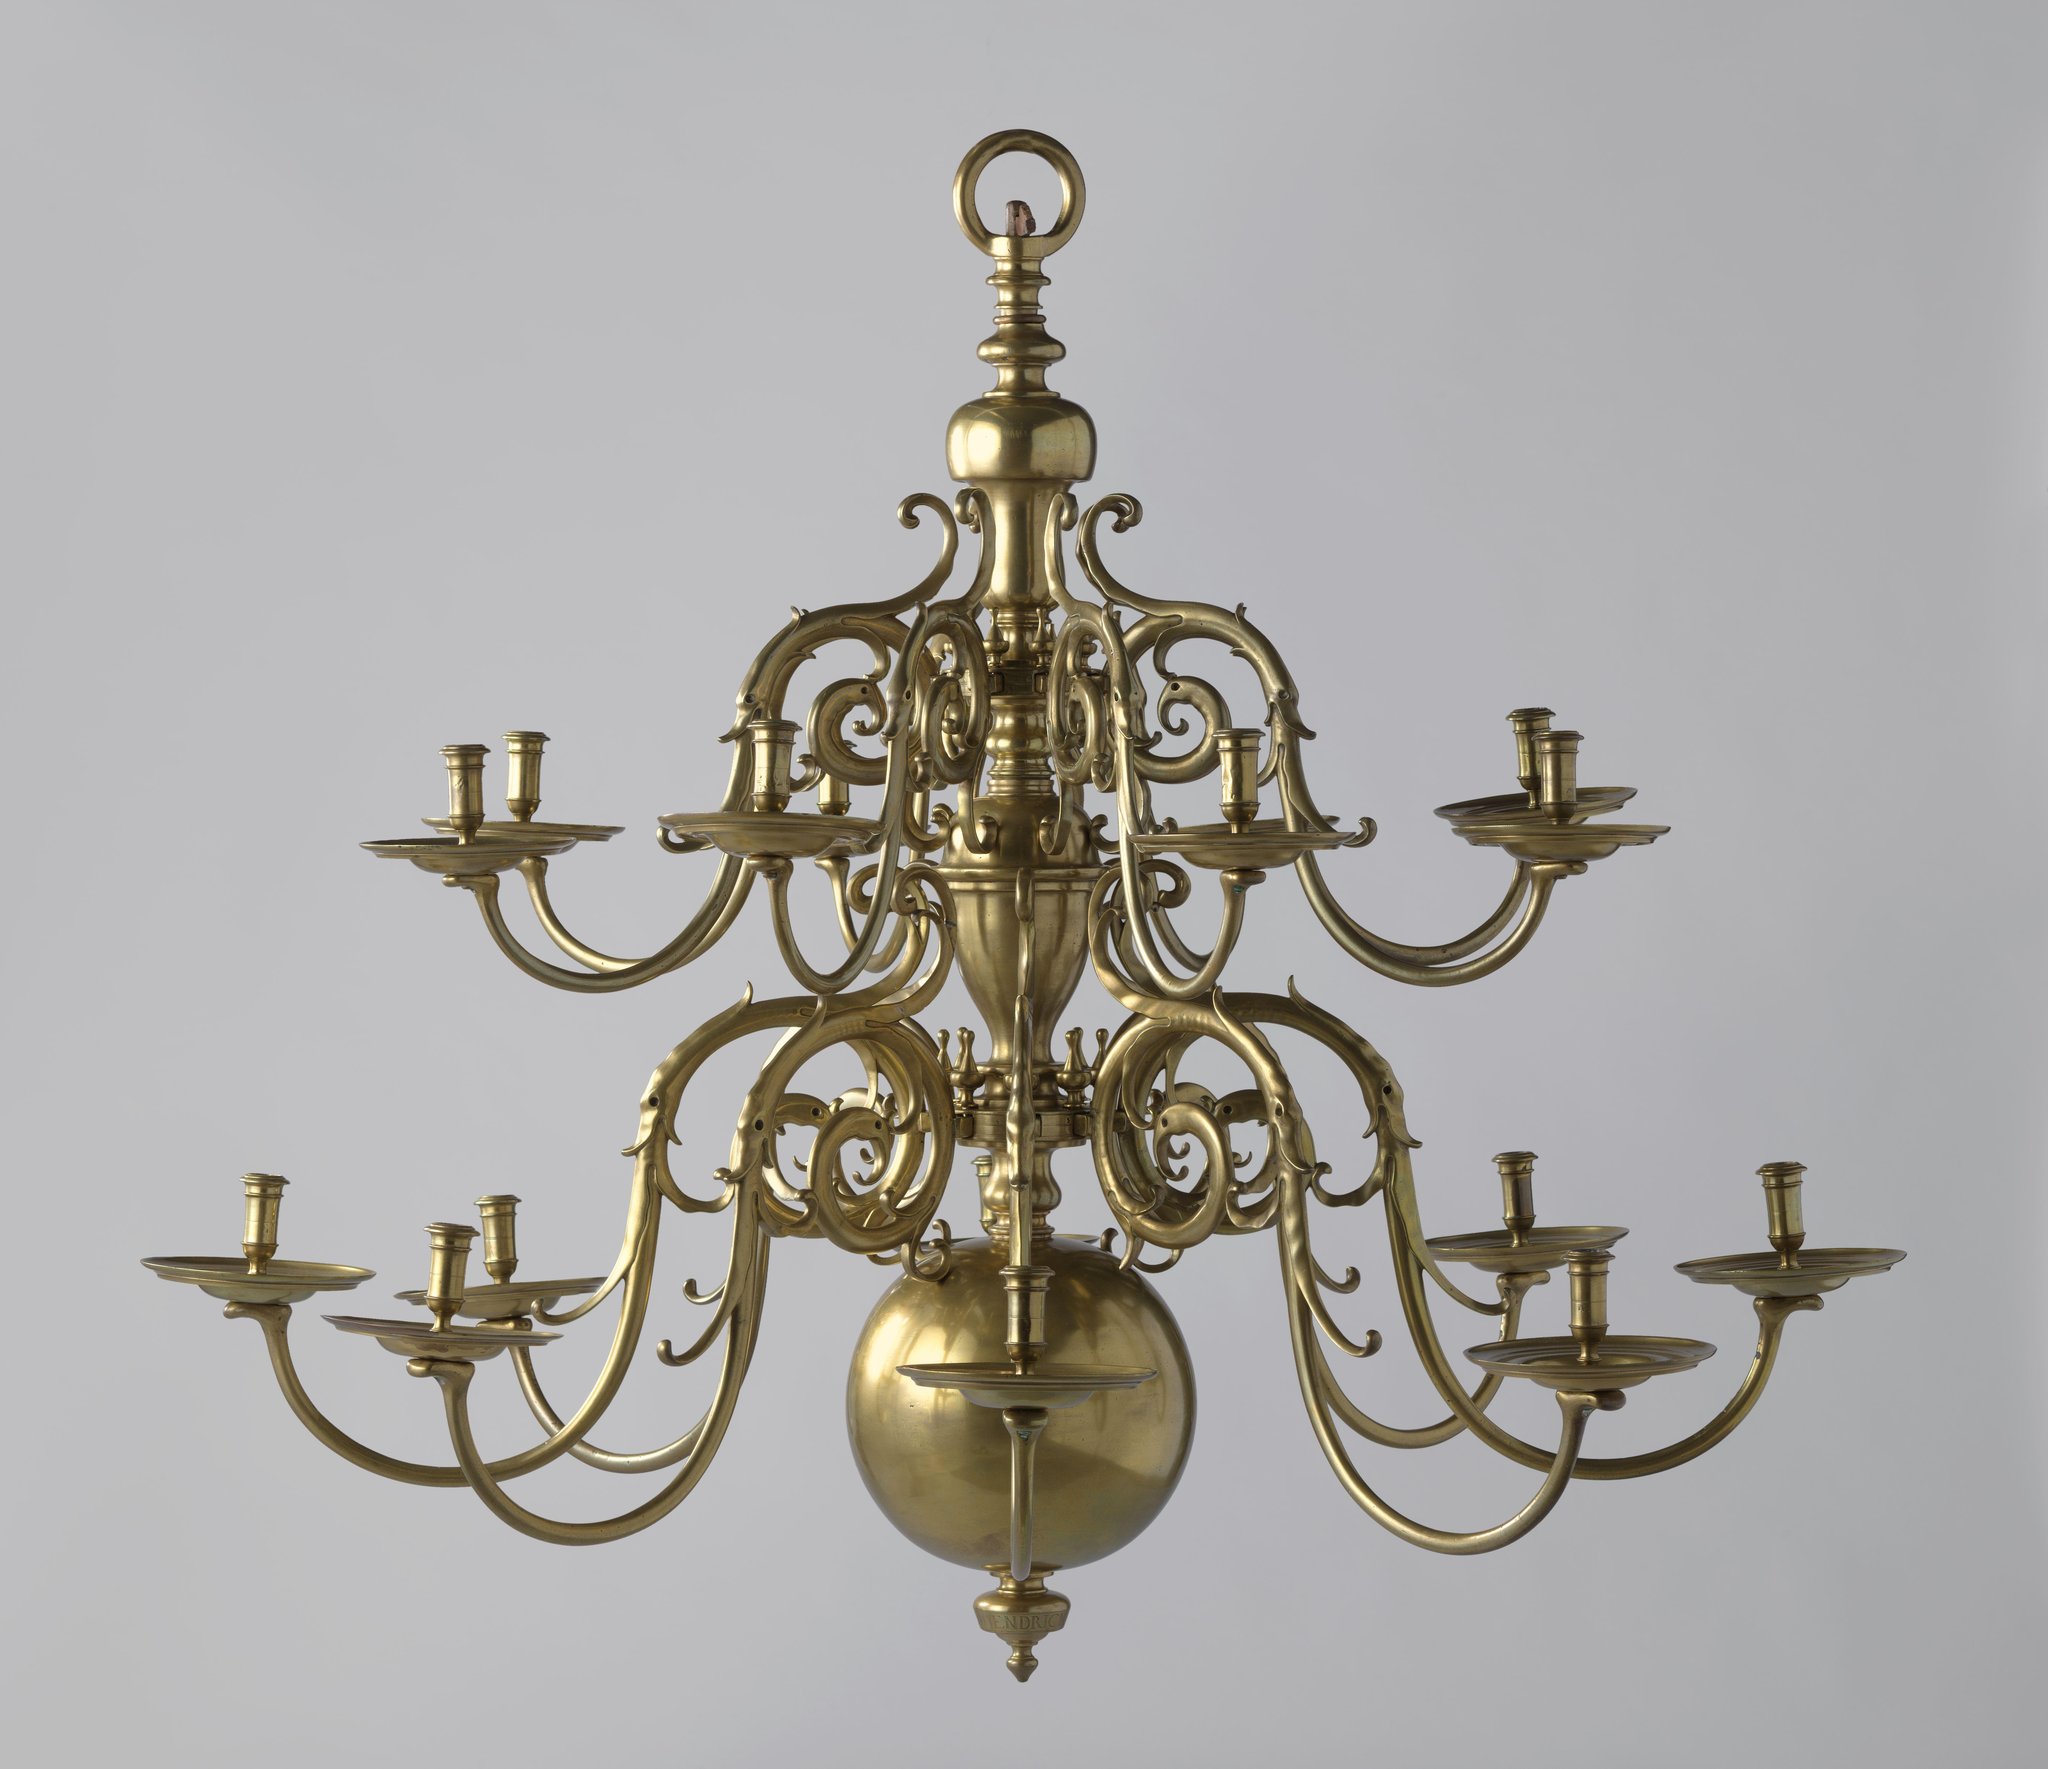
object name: chandelier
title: Arm met kaarsenhouder van kaarsenkroon van twee hoogten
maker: Anonymous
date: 1650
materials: brass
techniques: casting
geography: amsterdam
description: Kaarsenarm behorende bij een messing kaarsenkroon van twee hoogten. De S-vormige arm heeft een krul bij de aanzet, halverwege een dolfijnenkop en gaat naar buiten toe over in het platte verdikking met een schroefgat. Daarin is de kaarsenhouder met de vetvanger vastgezet. De vetvanger is aan de onderzijde geribd geprofileerd rond de opening en heeft een naar onder en een iets uitstekend randje. De cylindrische kaarsenhouder heeft een geprofileerde en een uitstekende rand, twee gegroefde ringen, een rib en een geprofileerd smaller onderstuk, dat overgaat in een uitsteeksel met een schroefdraad met een centergat. De pin om de arm te bevestigen is kegelvormig met een ronde knop bovenop. De vetvanger heeft een dichtgemaakt, rond gat, dat er op wijst dat de kaarsenkroon ooit geëlectrifieerd is geweest. Dit is de eerste arm van de bovenste standring, genummerd met het cijfer 6.